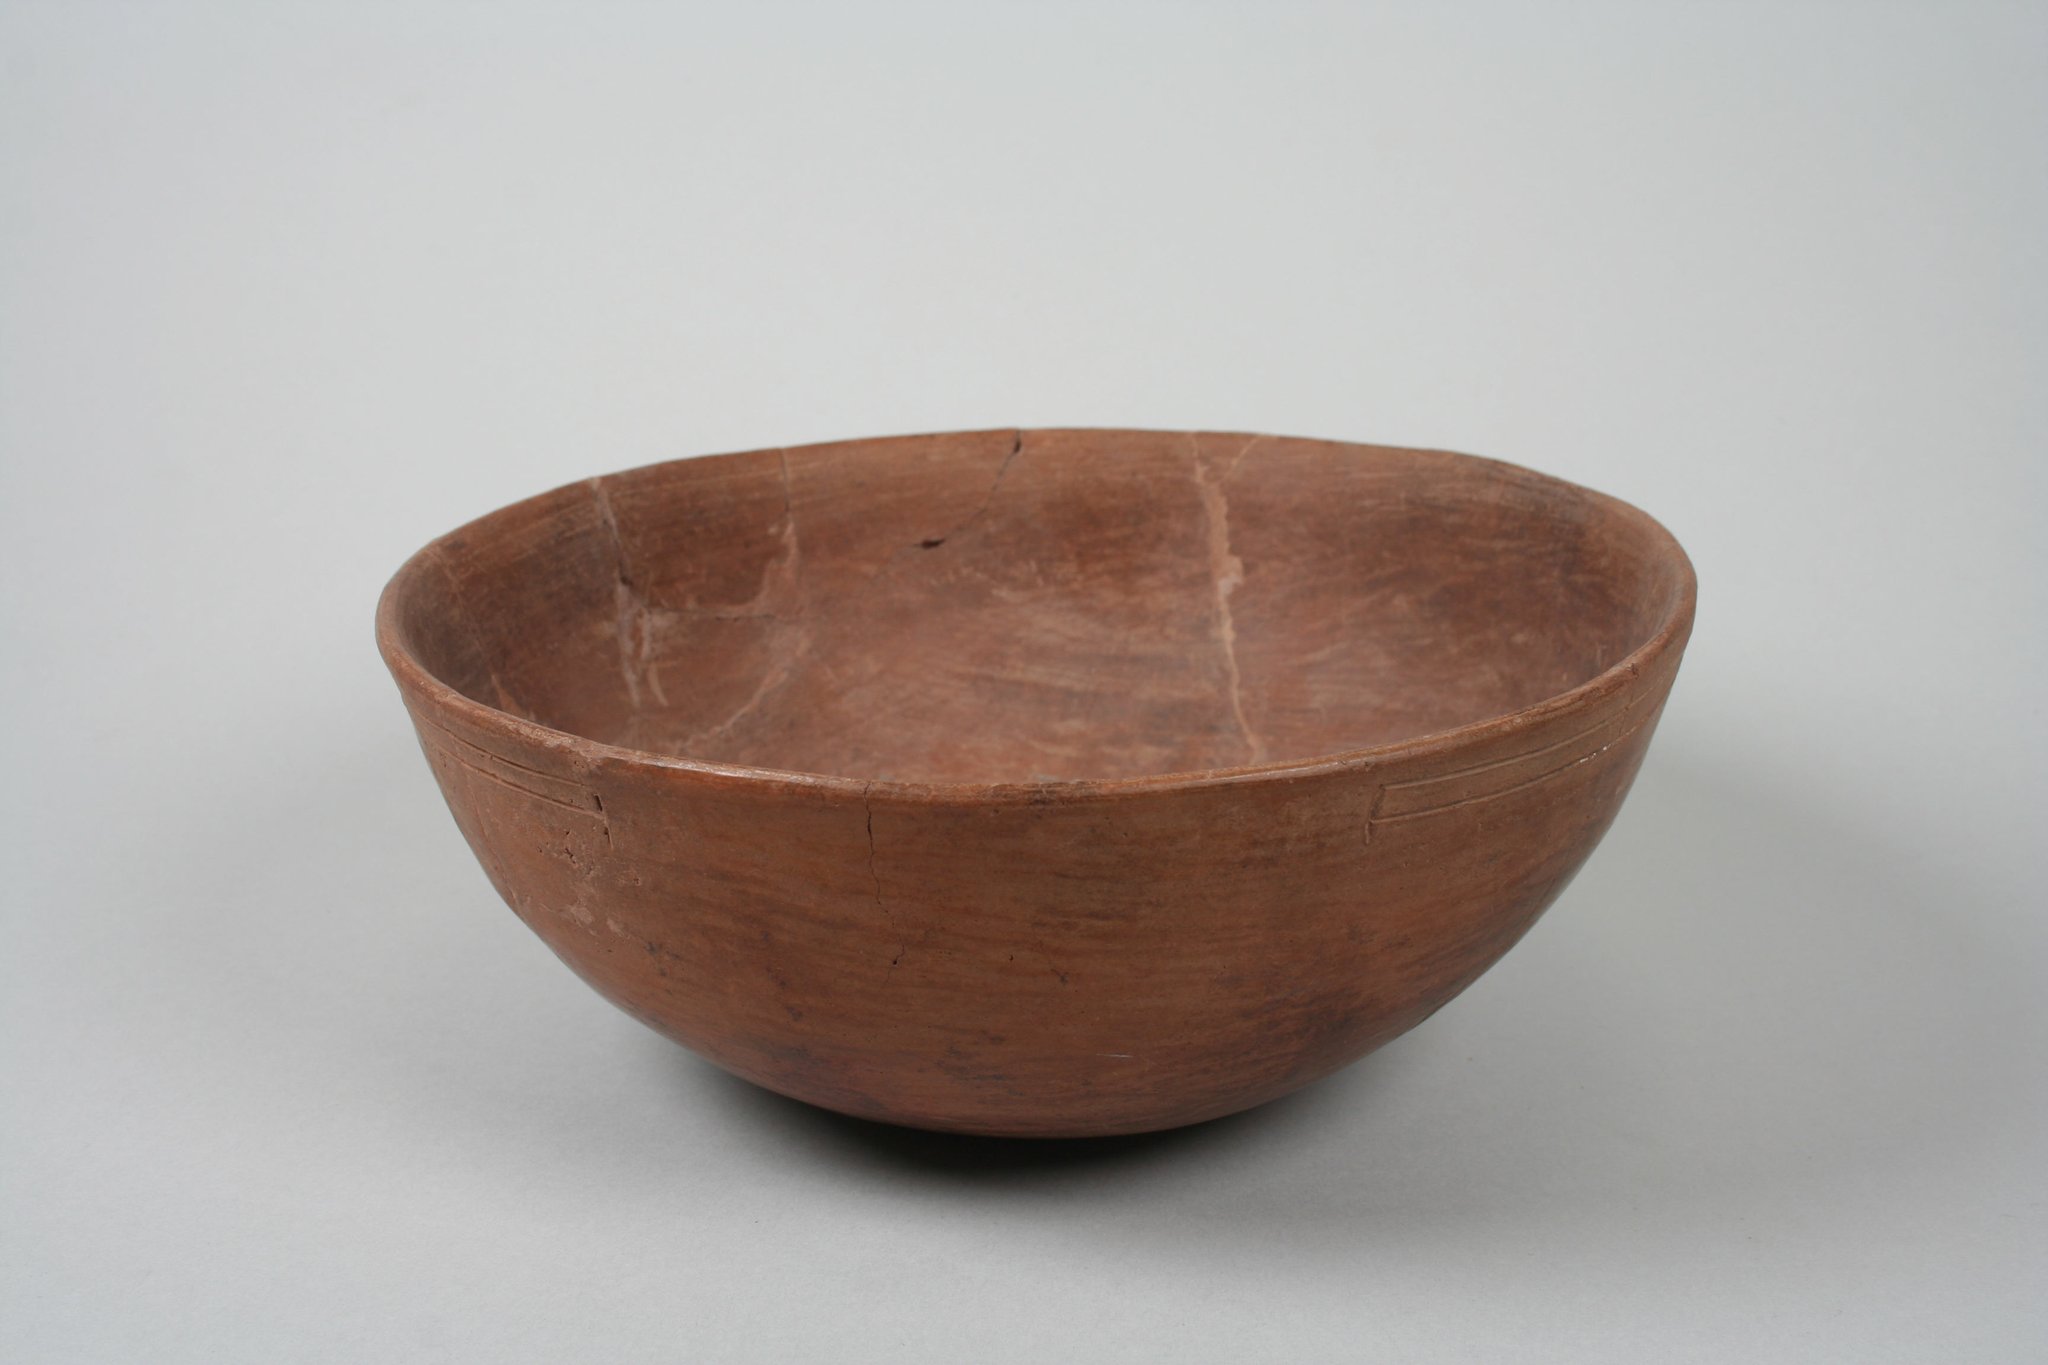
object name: bowl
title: Undecorated painted bowl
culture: paracas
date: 400-201 BCE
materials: ceramic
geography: peru